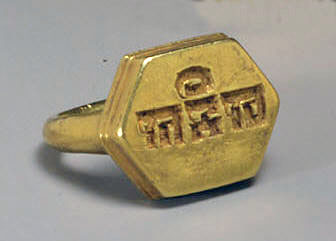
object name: ring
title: Ring with Plain Hexagonal Bezel and Java Kuno Script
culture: indonesian, javanese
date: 701-933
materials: gold